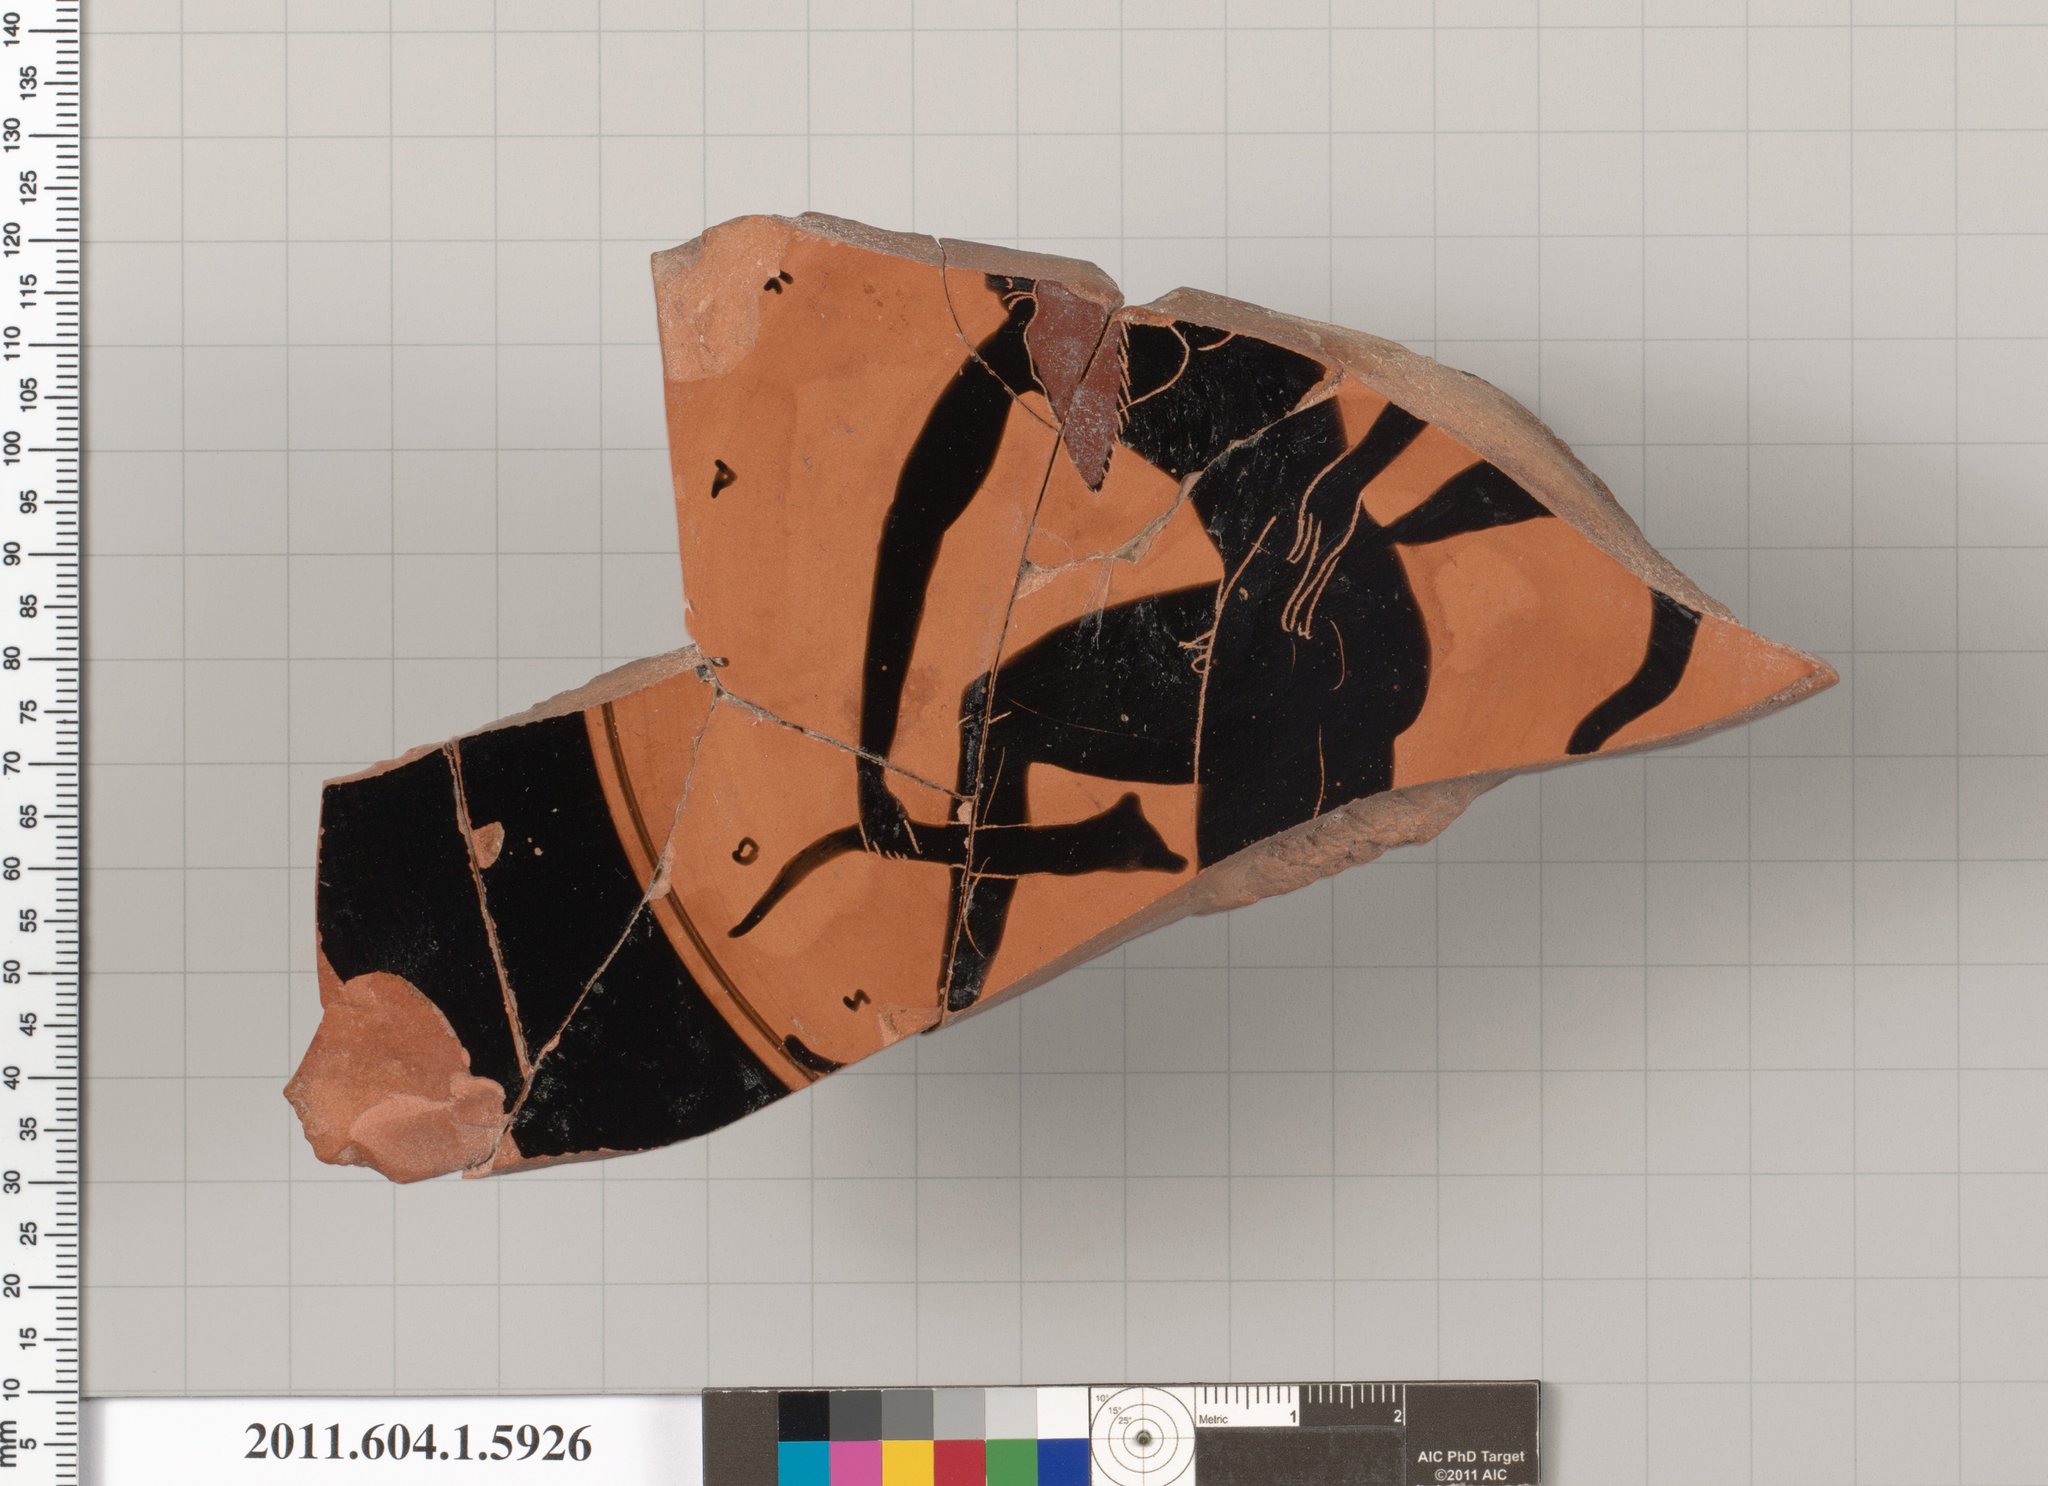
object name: kylix fragment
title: Terracotta fragment of a kylix (drinking cup)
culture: greek, attic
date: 433-567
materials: terracotta